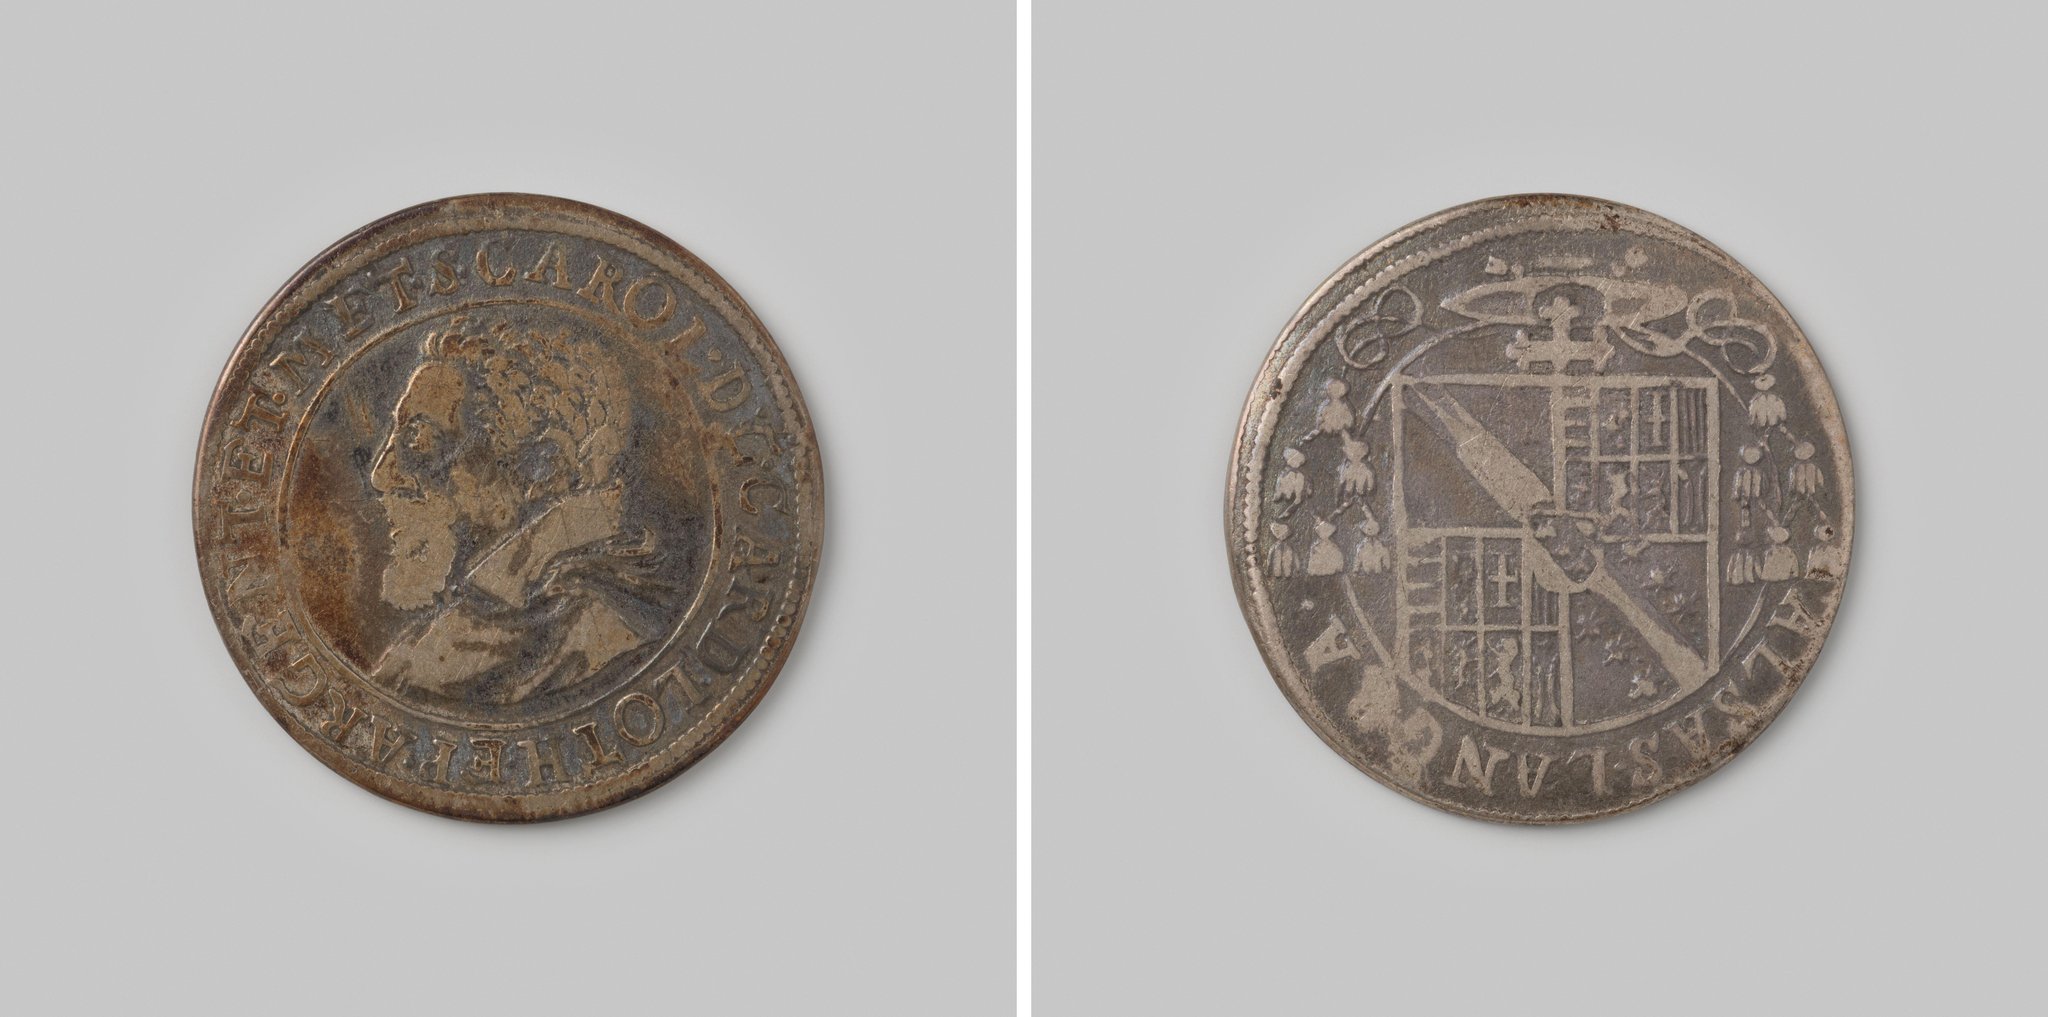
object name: coin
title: Kwart taler uit het bisdom Straatsburg, op naam van Karel van Lotharingen (1592-1608)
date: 1593-1607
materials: silver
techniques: striking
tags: nancy, kardinaal, bisschop, karl von lotharingen (hertog)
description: Zilveren munt. Voorzijde: portret naar links. Keerzijde: samengesteld wapenschild, waarboven bisschopshoed.